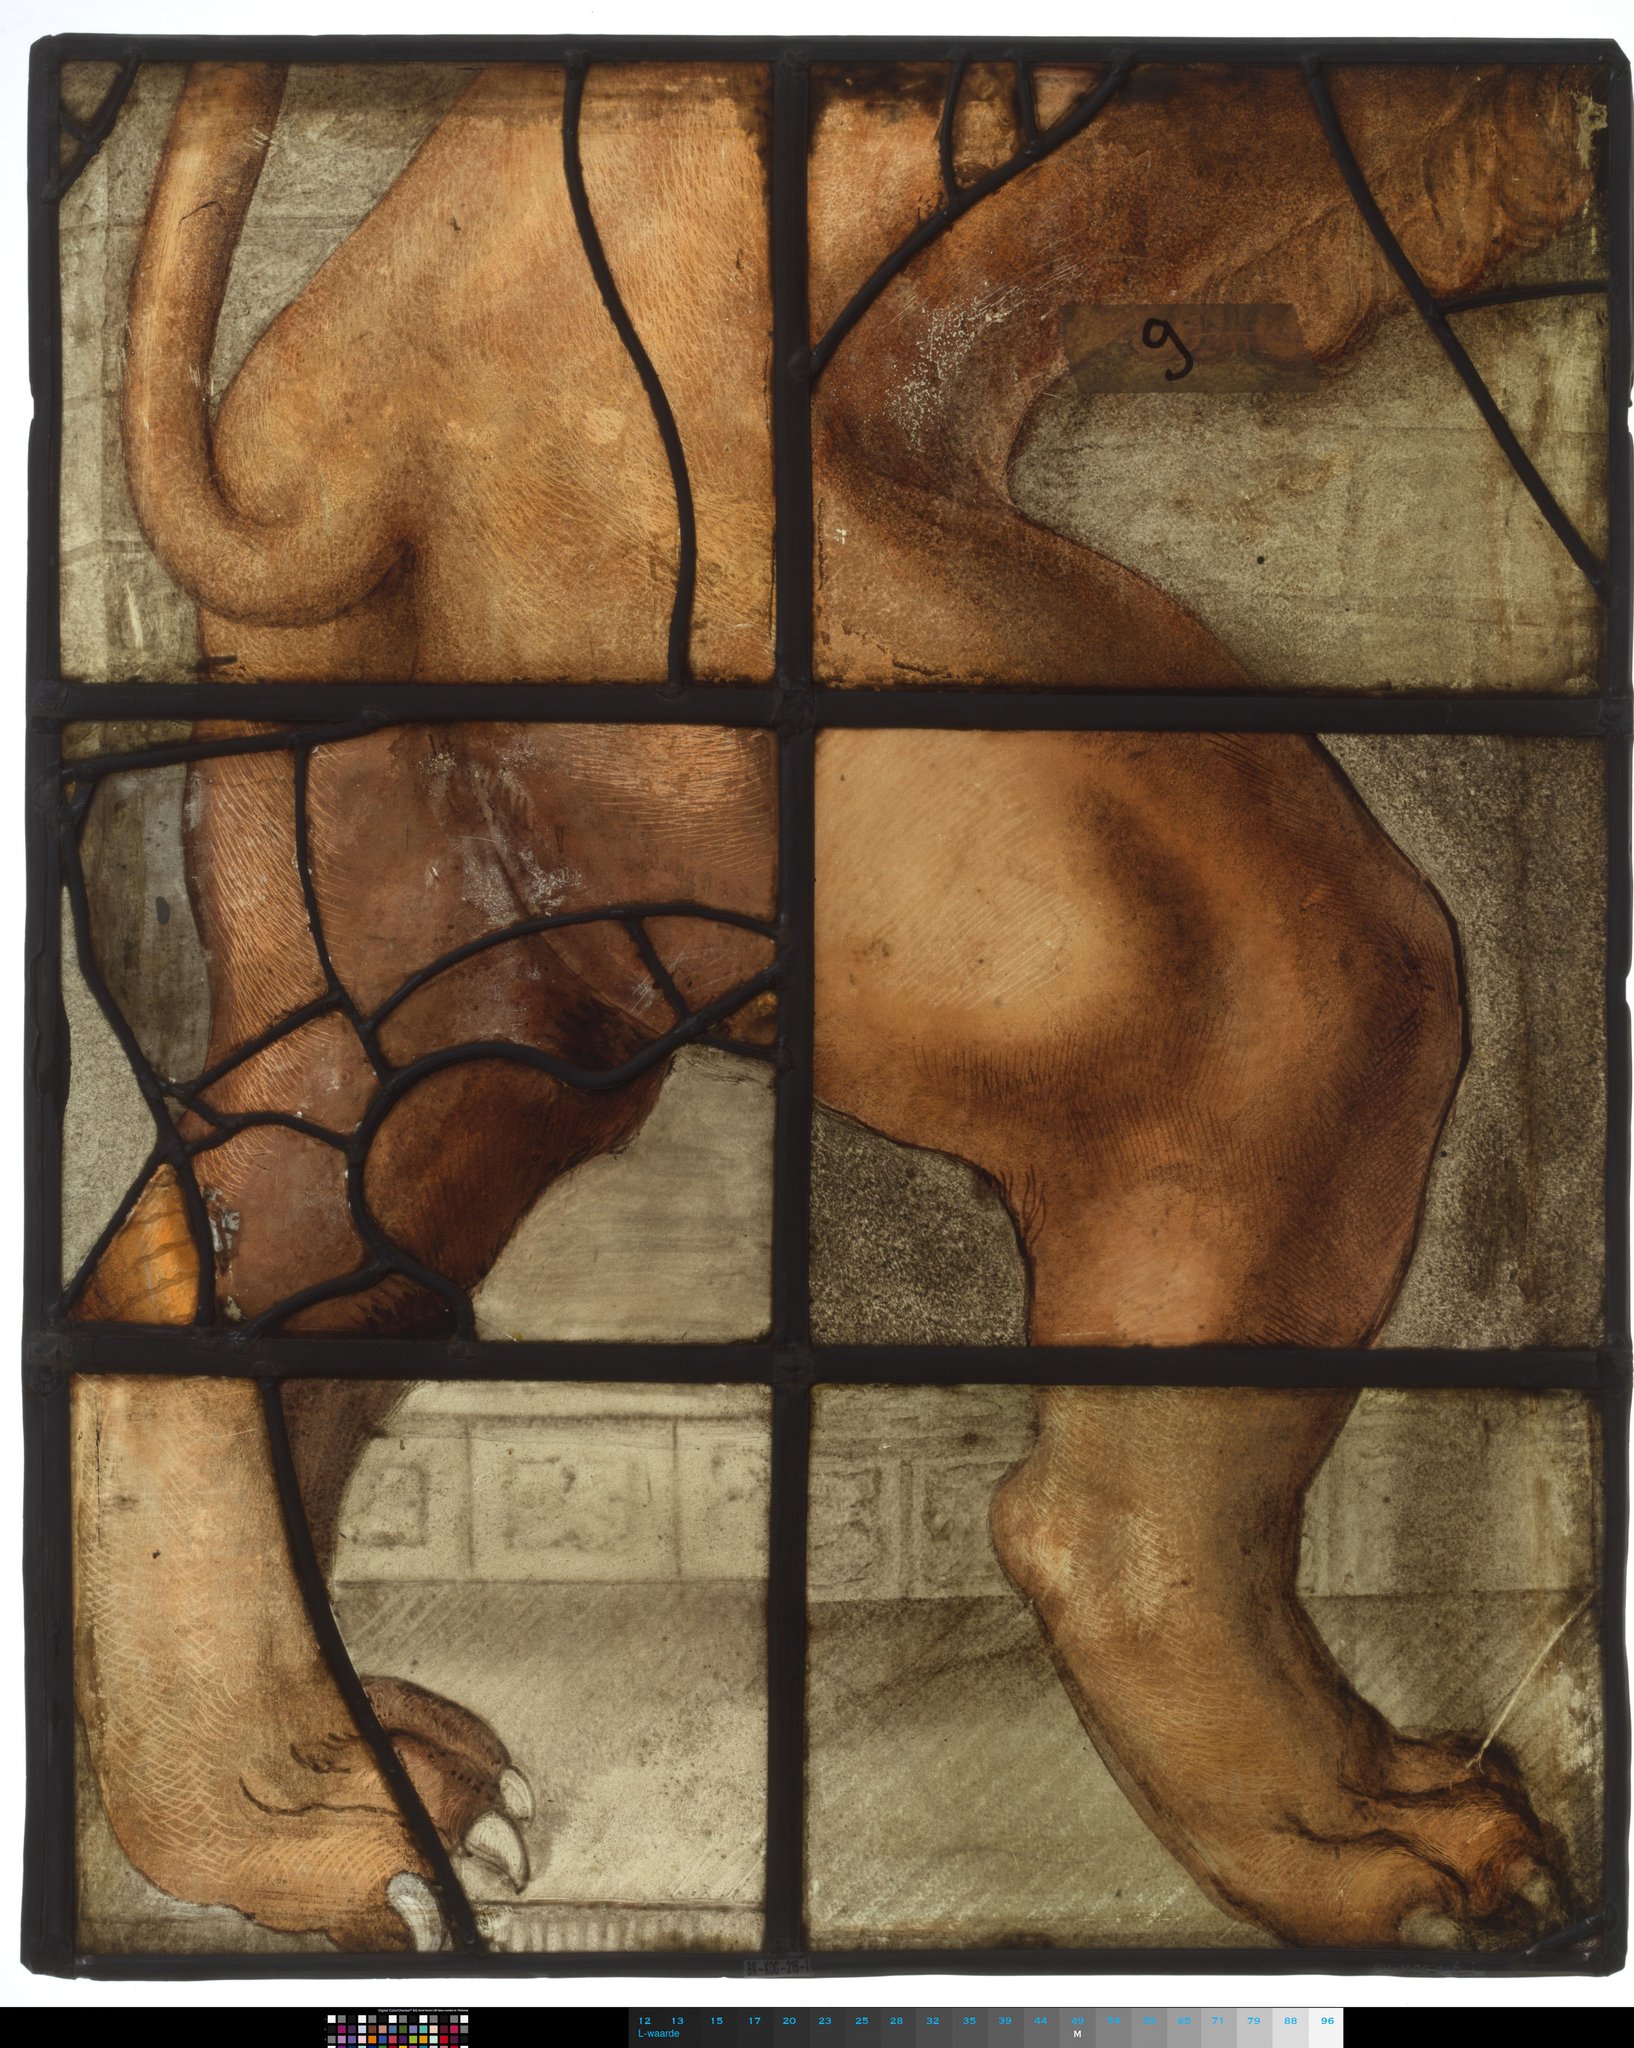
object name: light window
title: Ruit met het wapen van Alkmaar met onderschrift "Alkmaria Victrix 1573"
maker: Anonymous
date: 1573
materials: glass, lead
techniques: leading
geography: netherlands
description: Ruit, glas-in-lood, bestaande uit zestien afzonderlijke panelen die tezamen het wapen van Alkmaar laten zien. Onderschrift: ALKMARIA VICTRIX. Gedateerd 1573.